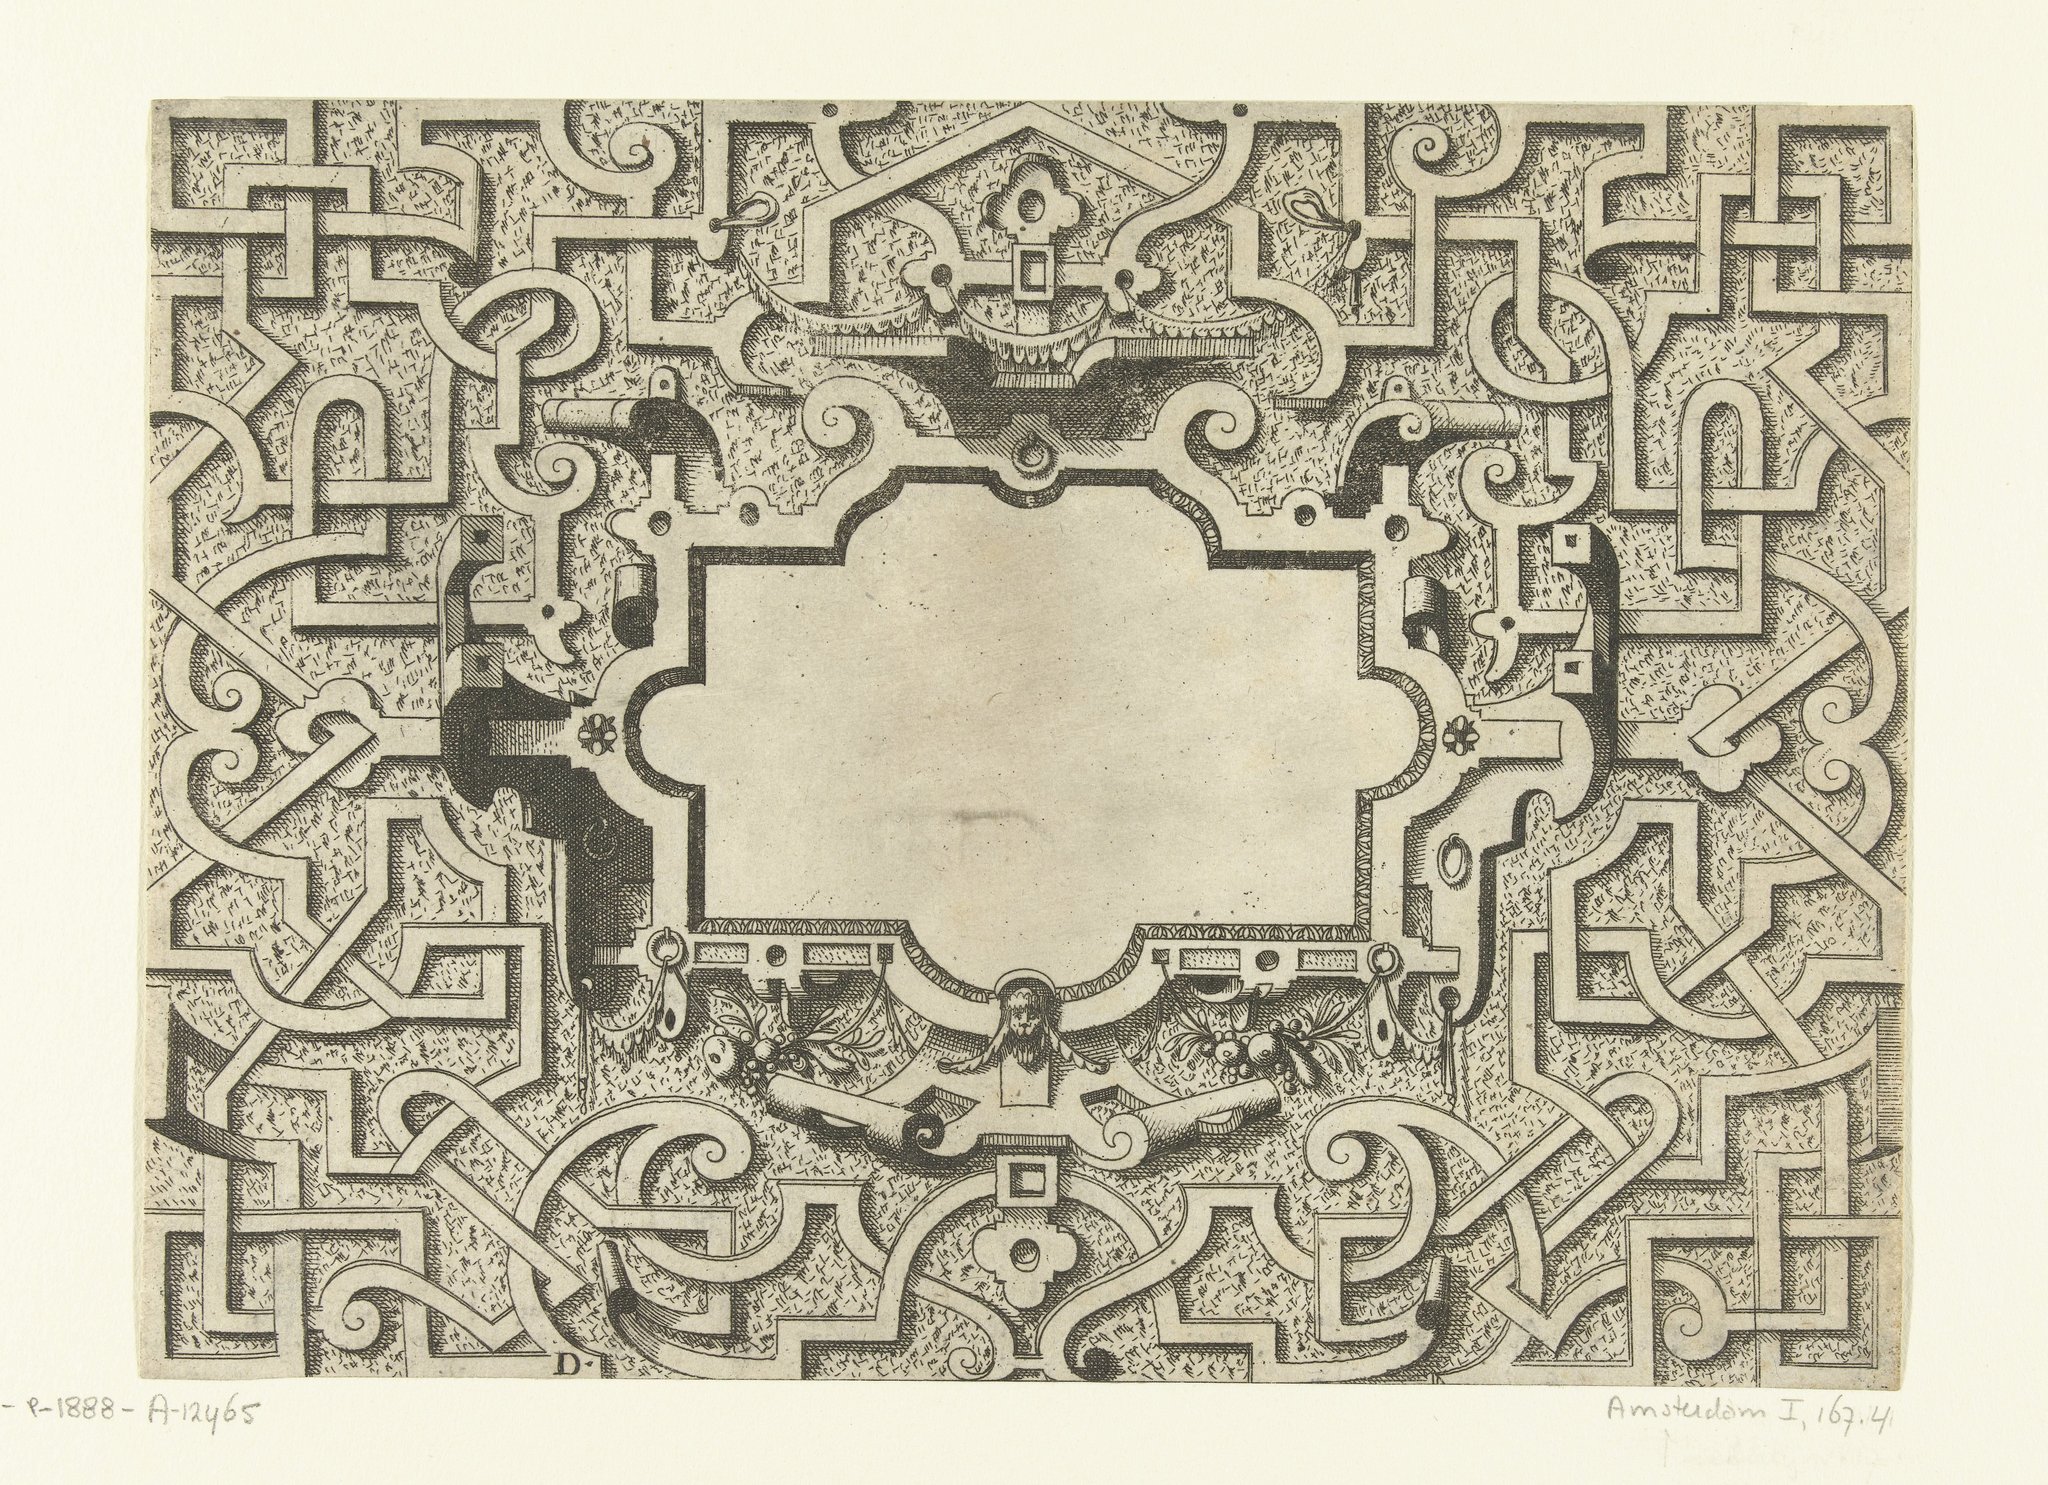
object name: print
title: Cartouche omgeven door moresken op een rustica-achtig fond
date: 1555-1560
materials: paper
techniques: etching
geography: netherlands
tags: ornament ~ moresque, ornament ~ cartouche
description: Blad D uit serie van 16 bladen, geletterd A-Q. Gearceerde of gestippelde achtergrond.